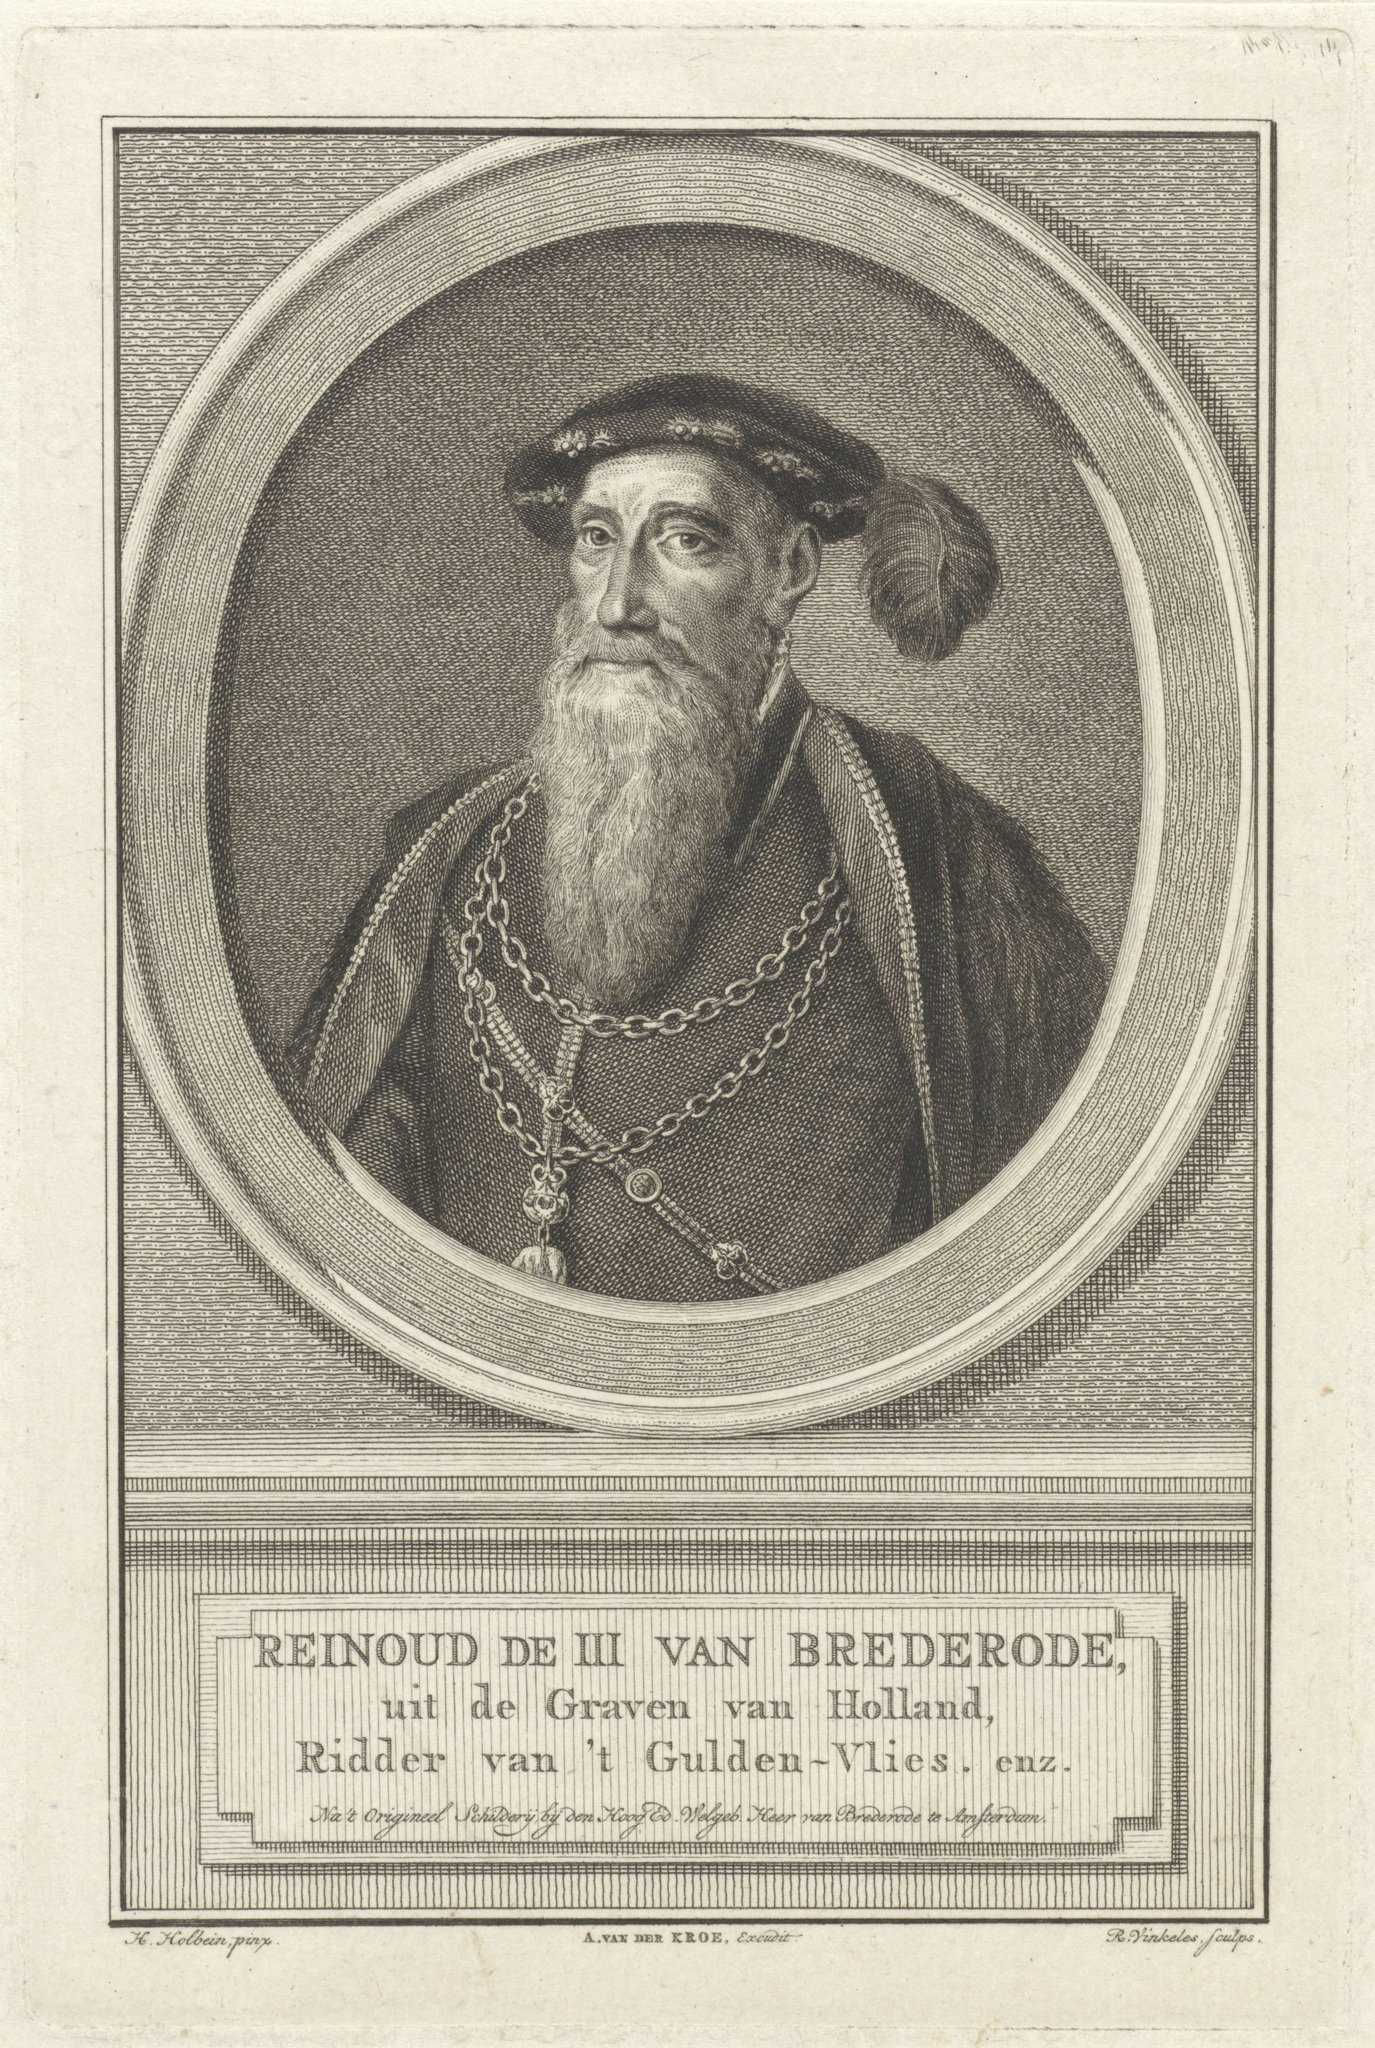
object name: print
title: Portret van Reinoud III van Brederode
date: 1758-1816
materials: paper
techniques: engraving, etching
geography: amsterdam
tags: reinoud iii van brederode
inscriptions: collector's mark: Lugt 2228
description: Portret van Reinoud III van Brederode, ridder van het Gulden Vlies.